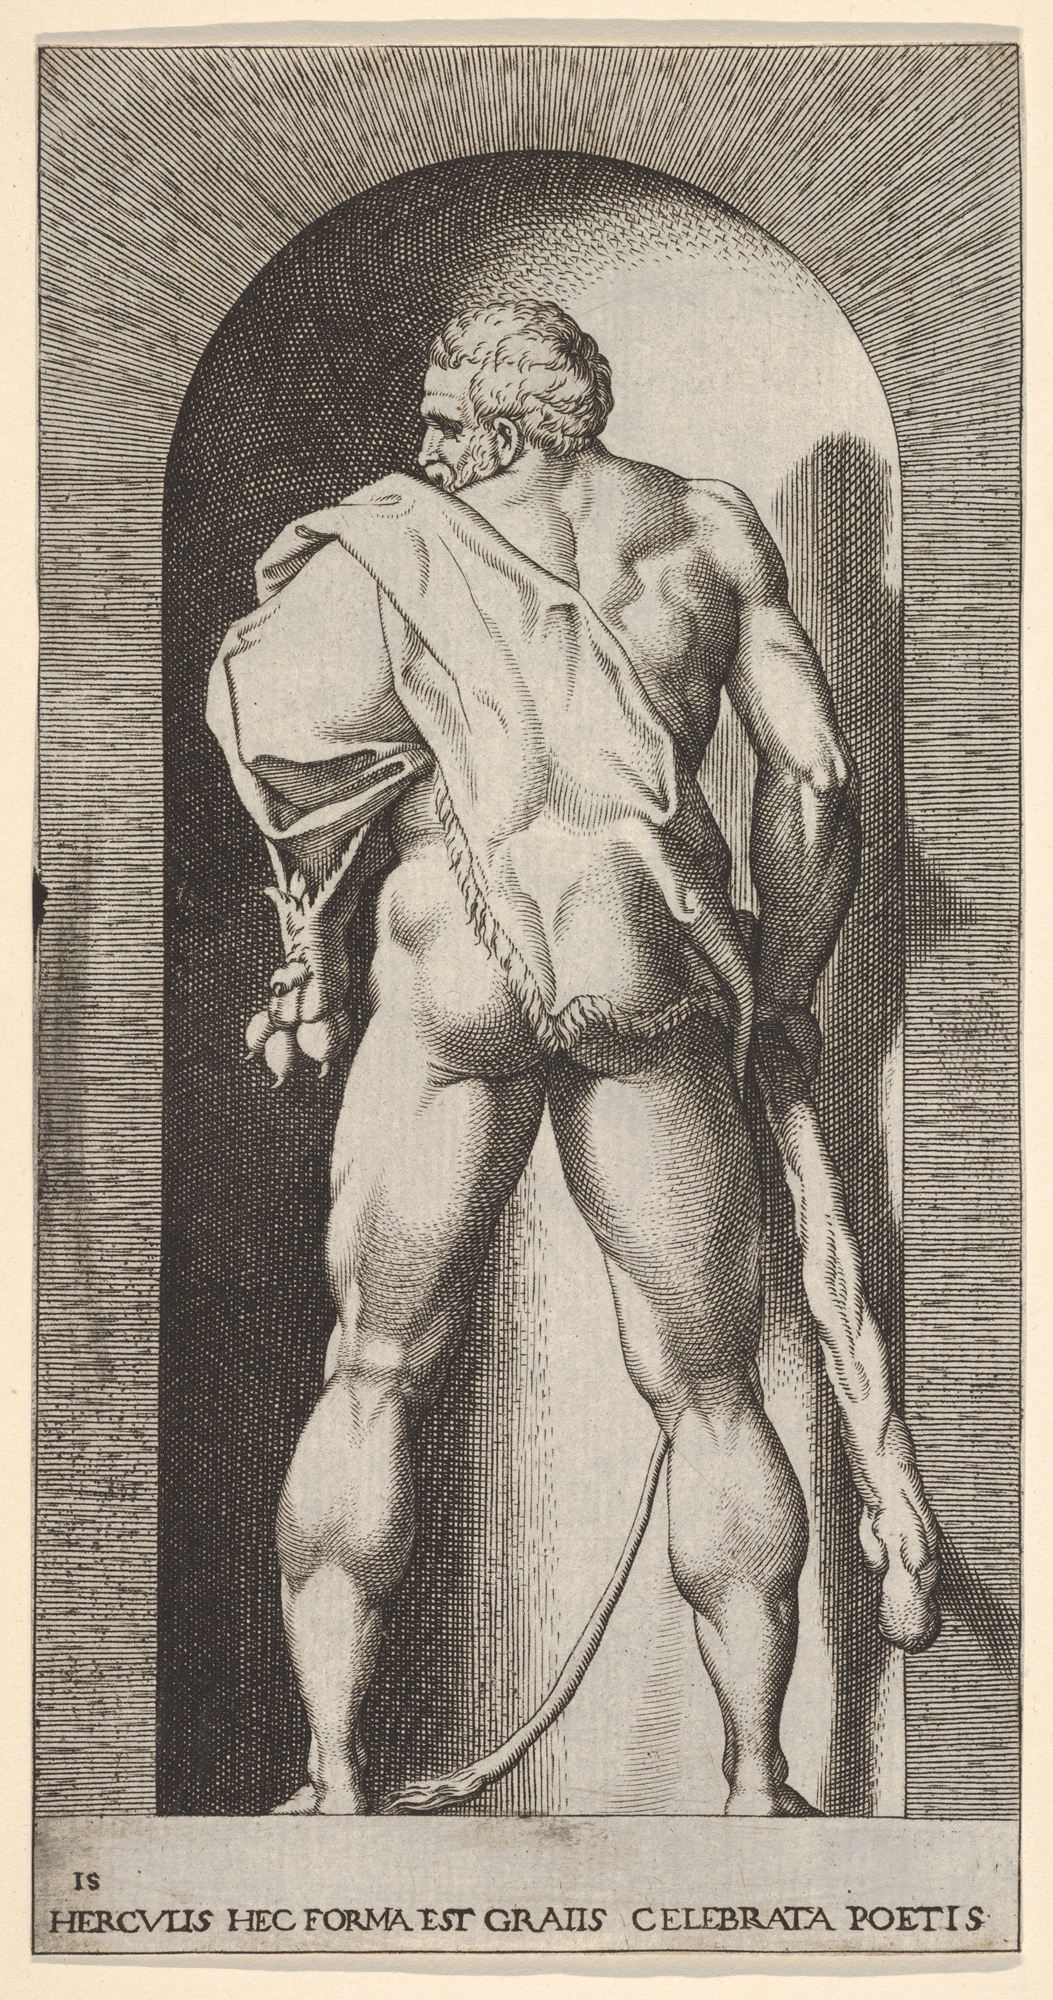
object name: print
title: Plate 15: Hercules standing in a niche, wearing a lion skin and holding a club, viewed from behind, with his head turned to the left, from "Mythological Gods and Goddesses"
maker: giovanni jacopo caraglio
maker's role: artist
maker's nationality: italian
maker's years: 1500-1565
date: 1526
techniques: engraving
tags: weapons,hercules